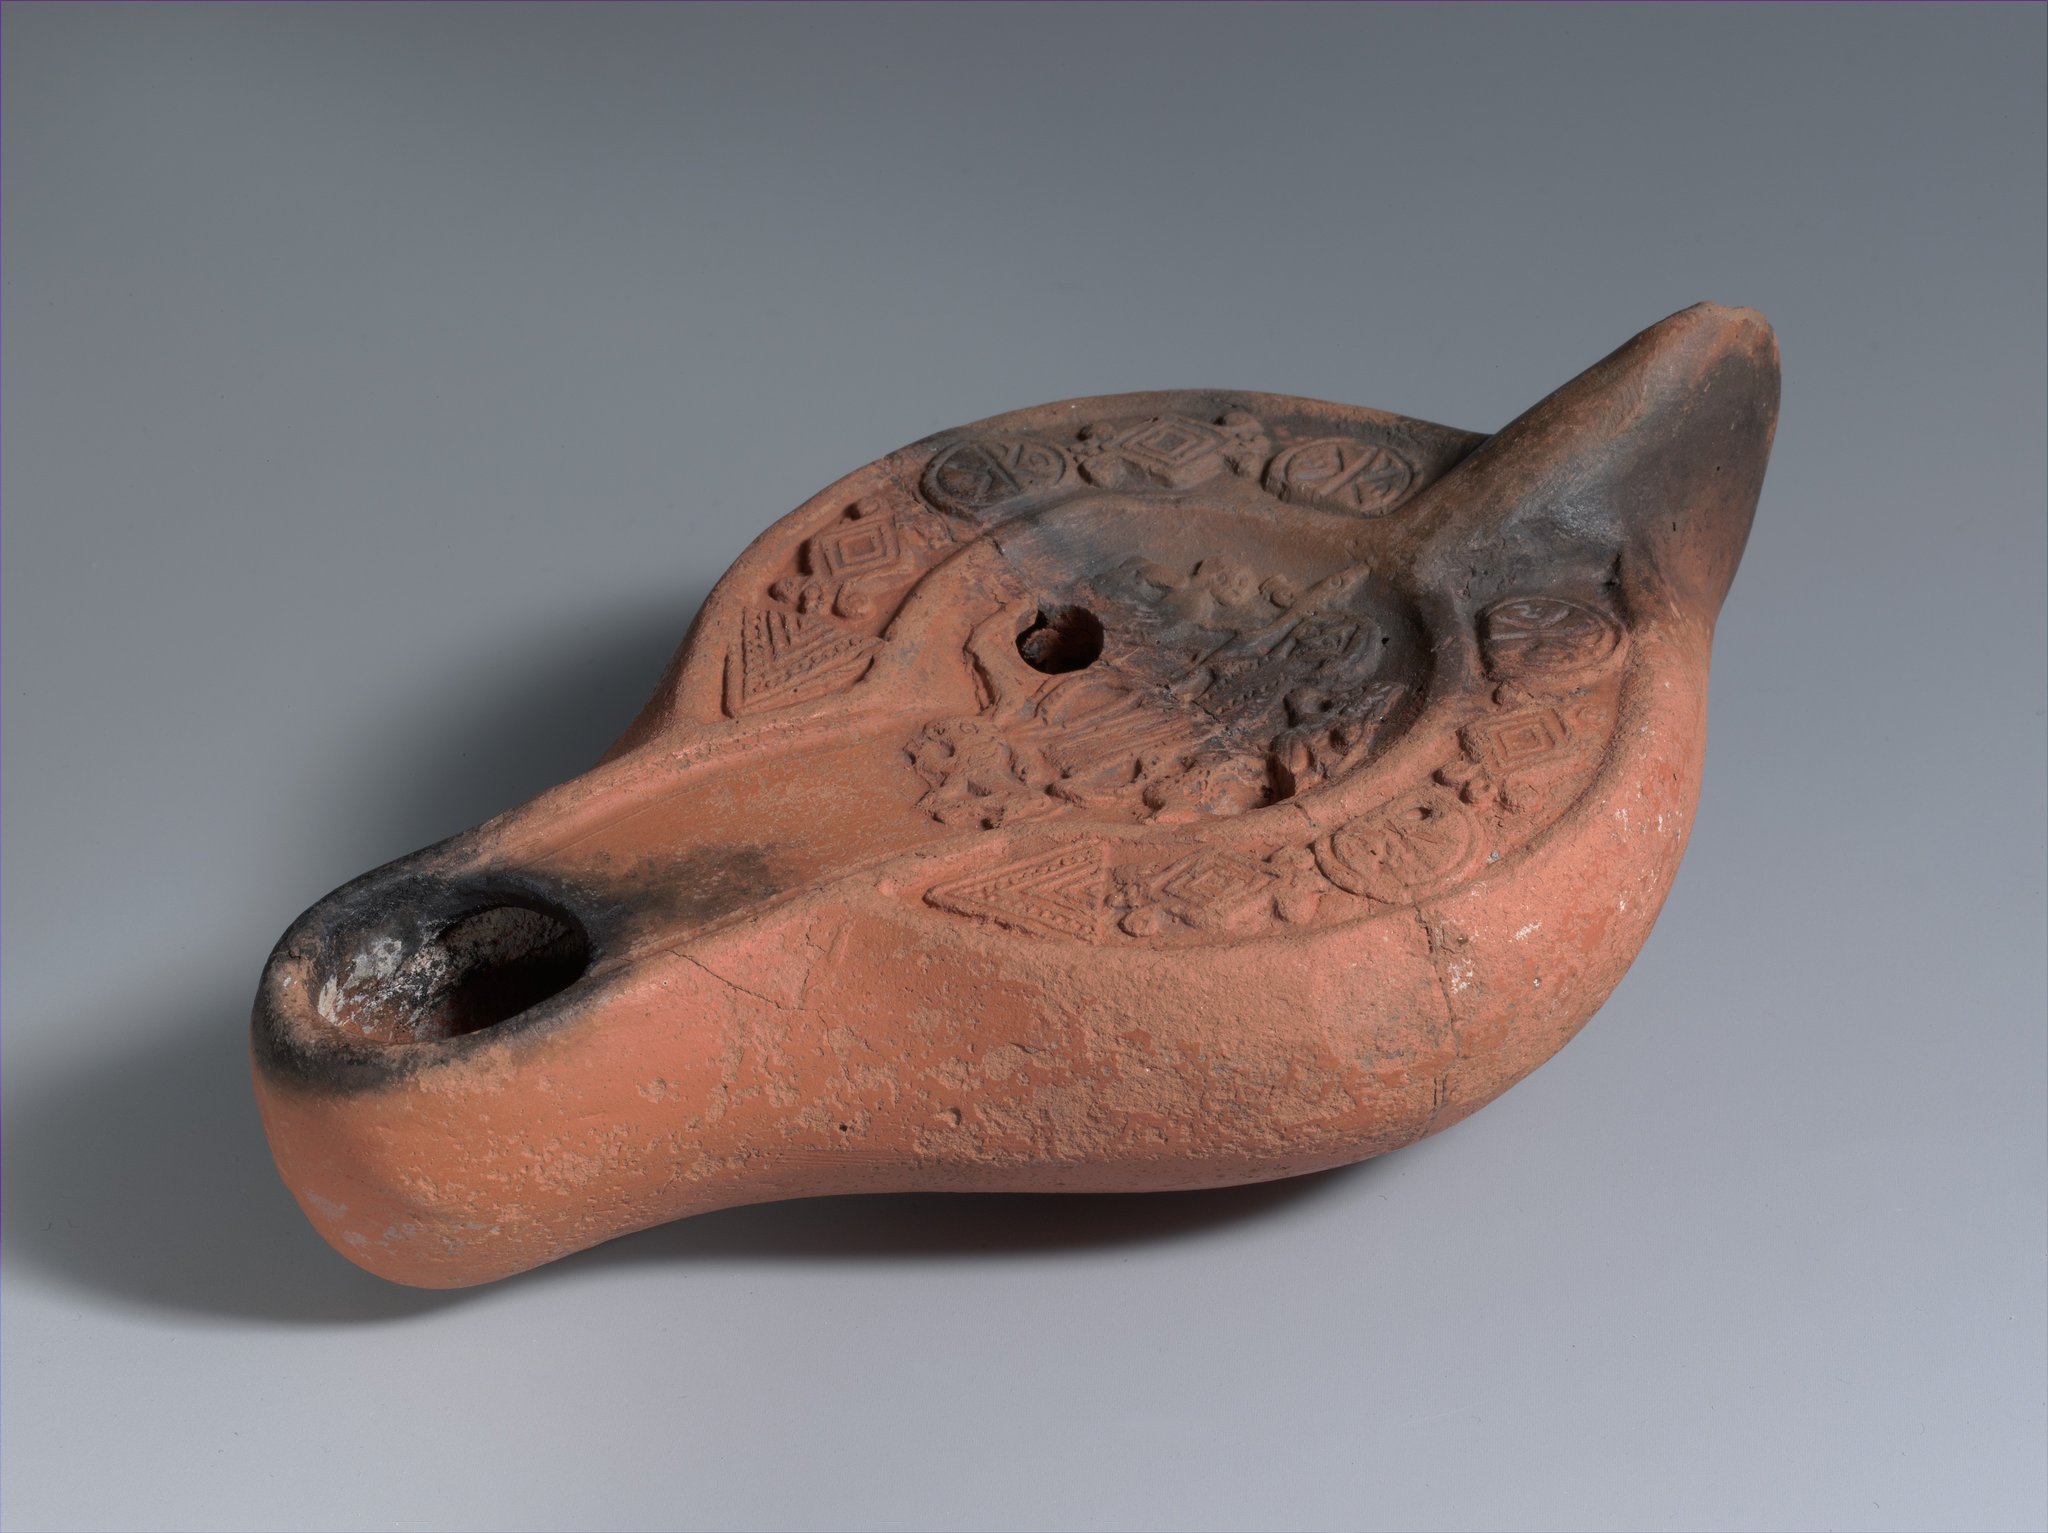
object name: lamp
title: Lamp with Christ Trampling the Beasts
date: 401-500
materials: earthenware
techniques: molding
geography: tunisia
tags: dragons,lions,angels,christ